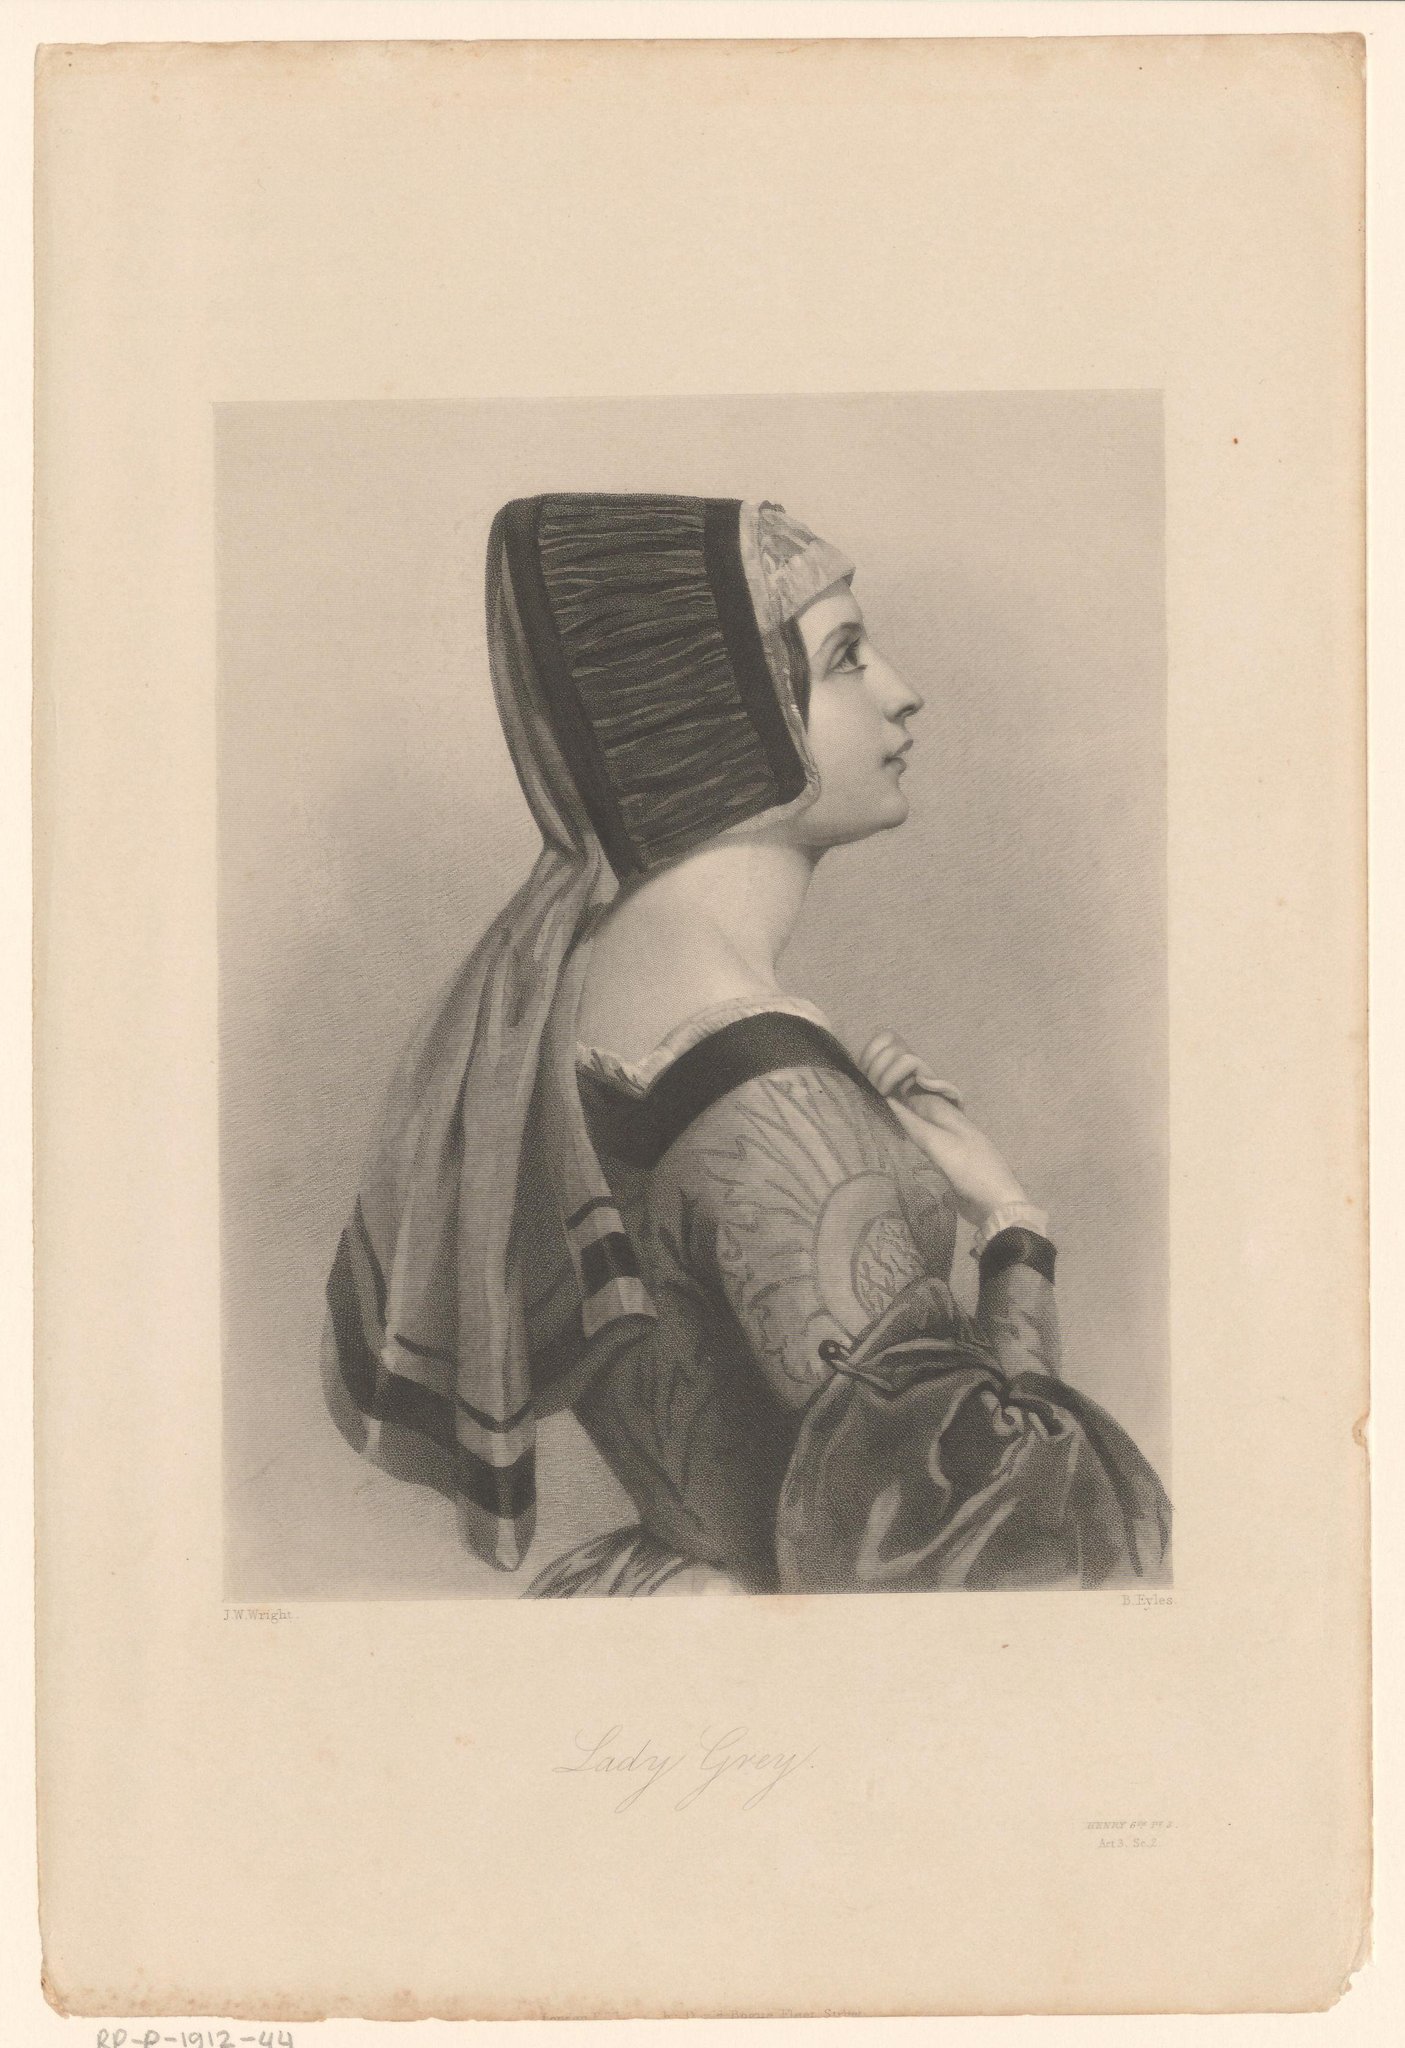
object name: print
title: Mevrouw Grey, uit Shakespeare's Hendrik IV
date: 1847-1848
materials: paper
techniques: etching, roulette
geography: london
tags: william shakespeare, female literary characters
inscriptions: collector's mark: Lugt 2228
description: Prent ook gebruikt in: Heath, Charles. The heroines of Shakespeare: comprising the principal female characters in the plays of the great poet. Londen: David Bogue, 1848.